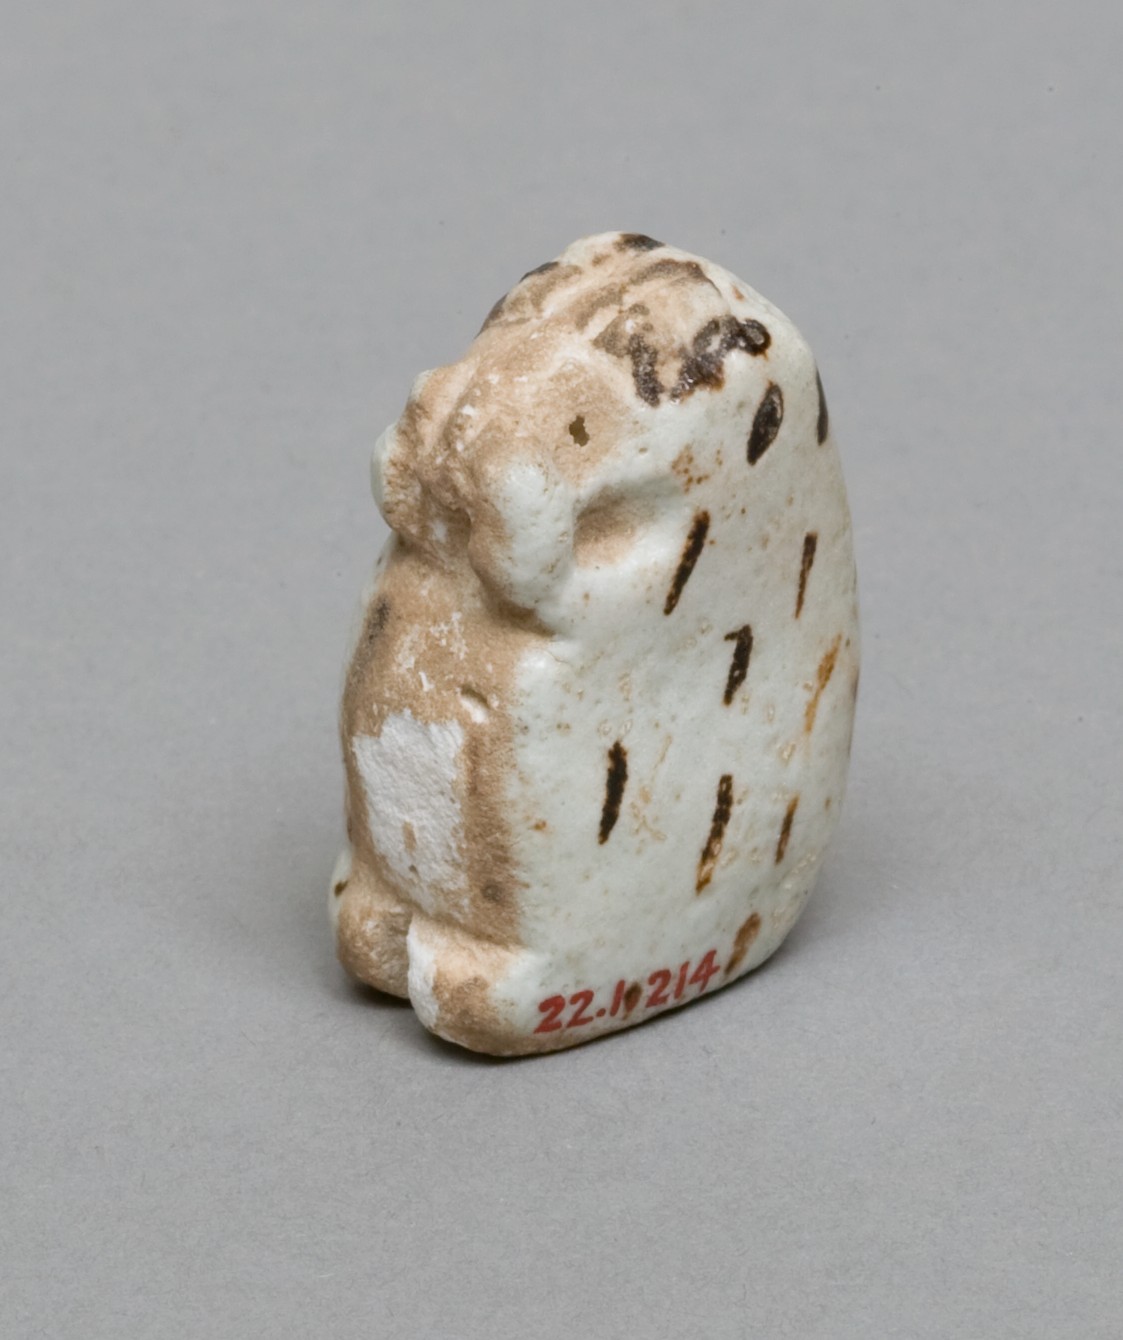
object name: figurine, jerboa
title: Figurine of a jerboa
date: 1802-1640 BCE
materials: faience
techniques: painting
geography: egypt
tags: animals